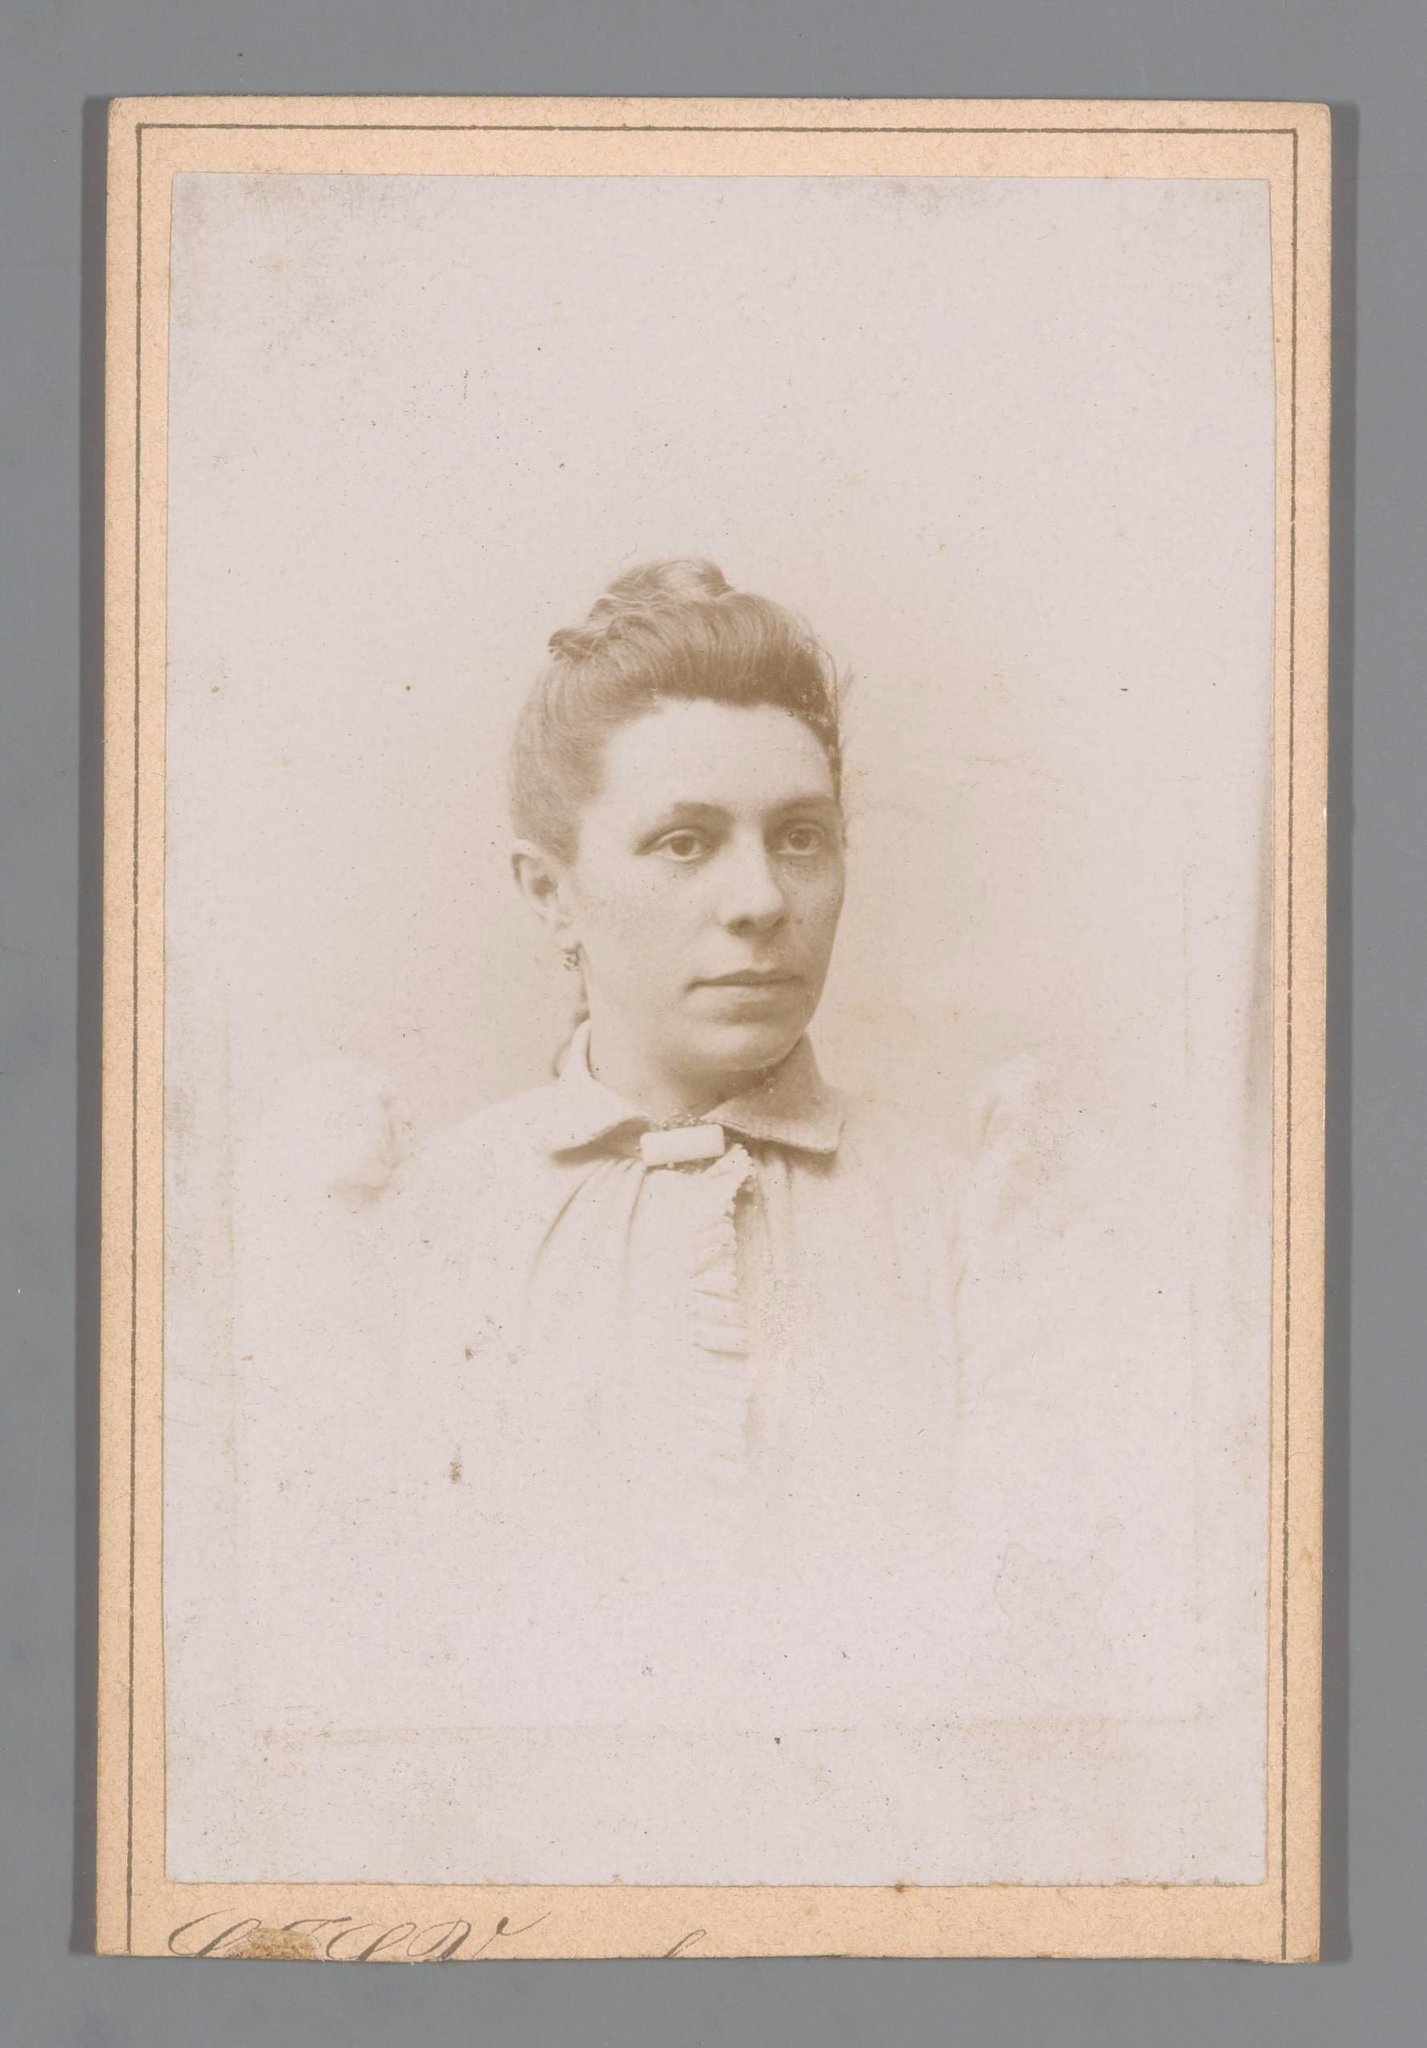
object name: photograph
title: Portret van een onbekende vrouw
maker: cornelis johannes lodewicus vermeulen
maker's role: fotograaf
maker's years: 1861-1936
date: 1888-1896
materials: cardboard, paper, photographic support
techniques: daylight paper print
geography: amsterdam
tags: adult woman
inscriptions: inscription: ‘Photographische Ateliers C.J.L Vermeulen Heerenstraat 6, & Heiligenweg hoek Singel Amsterdam.’